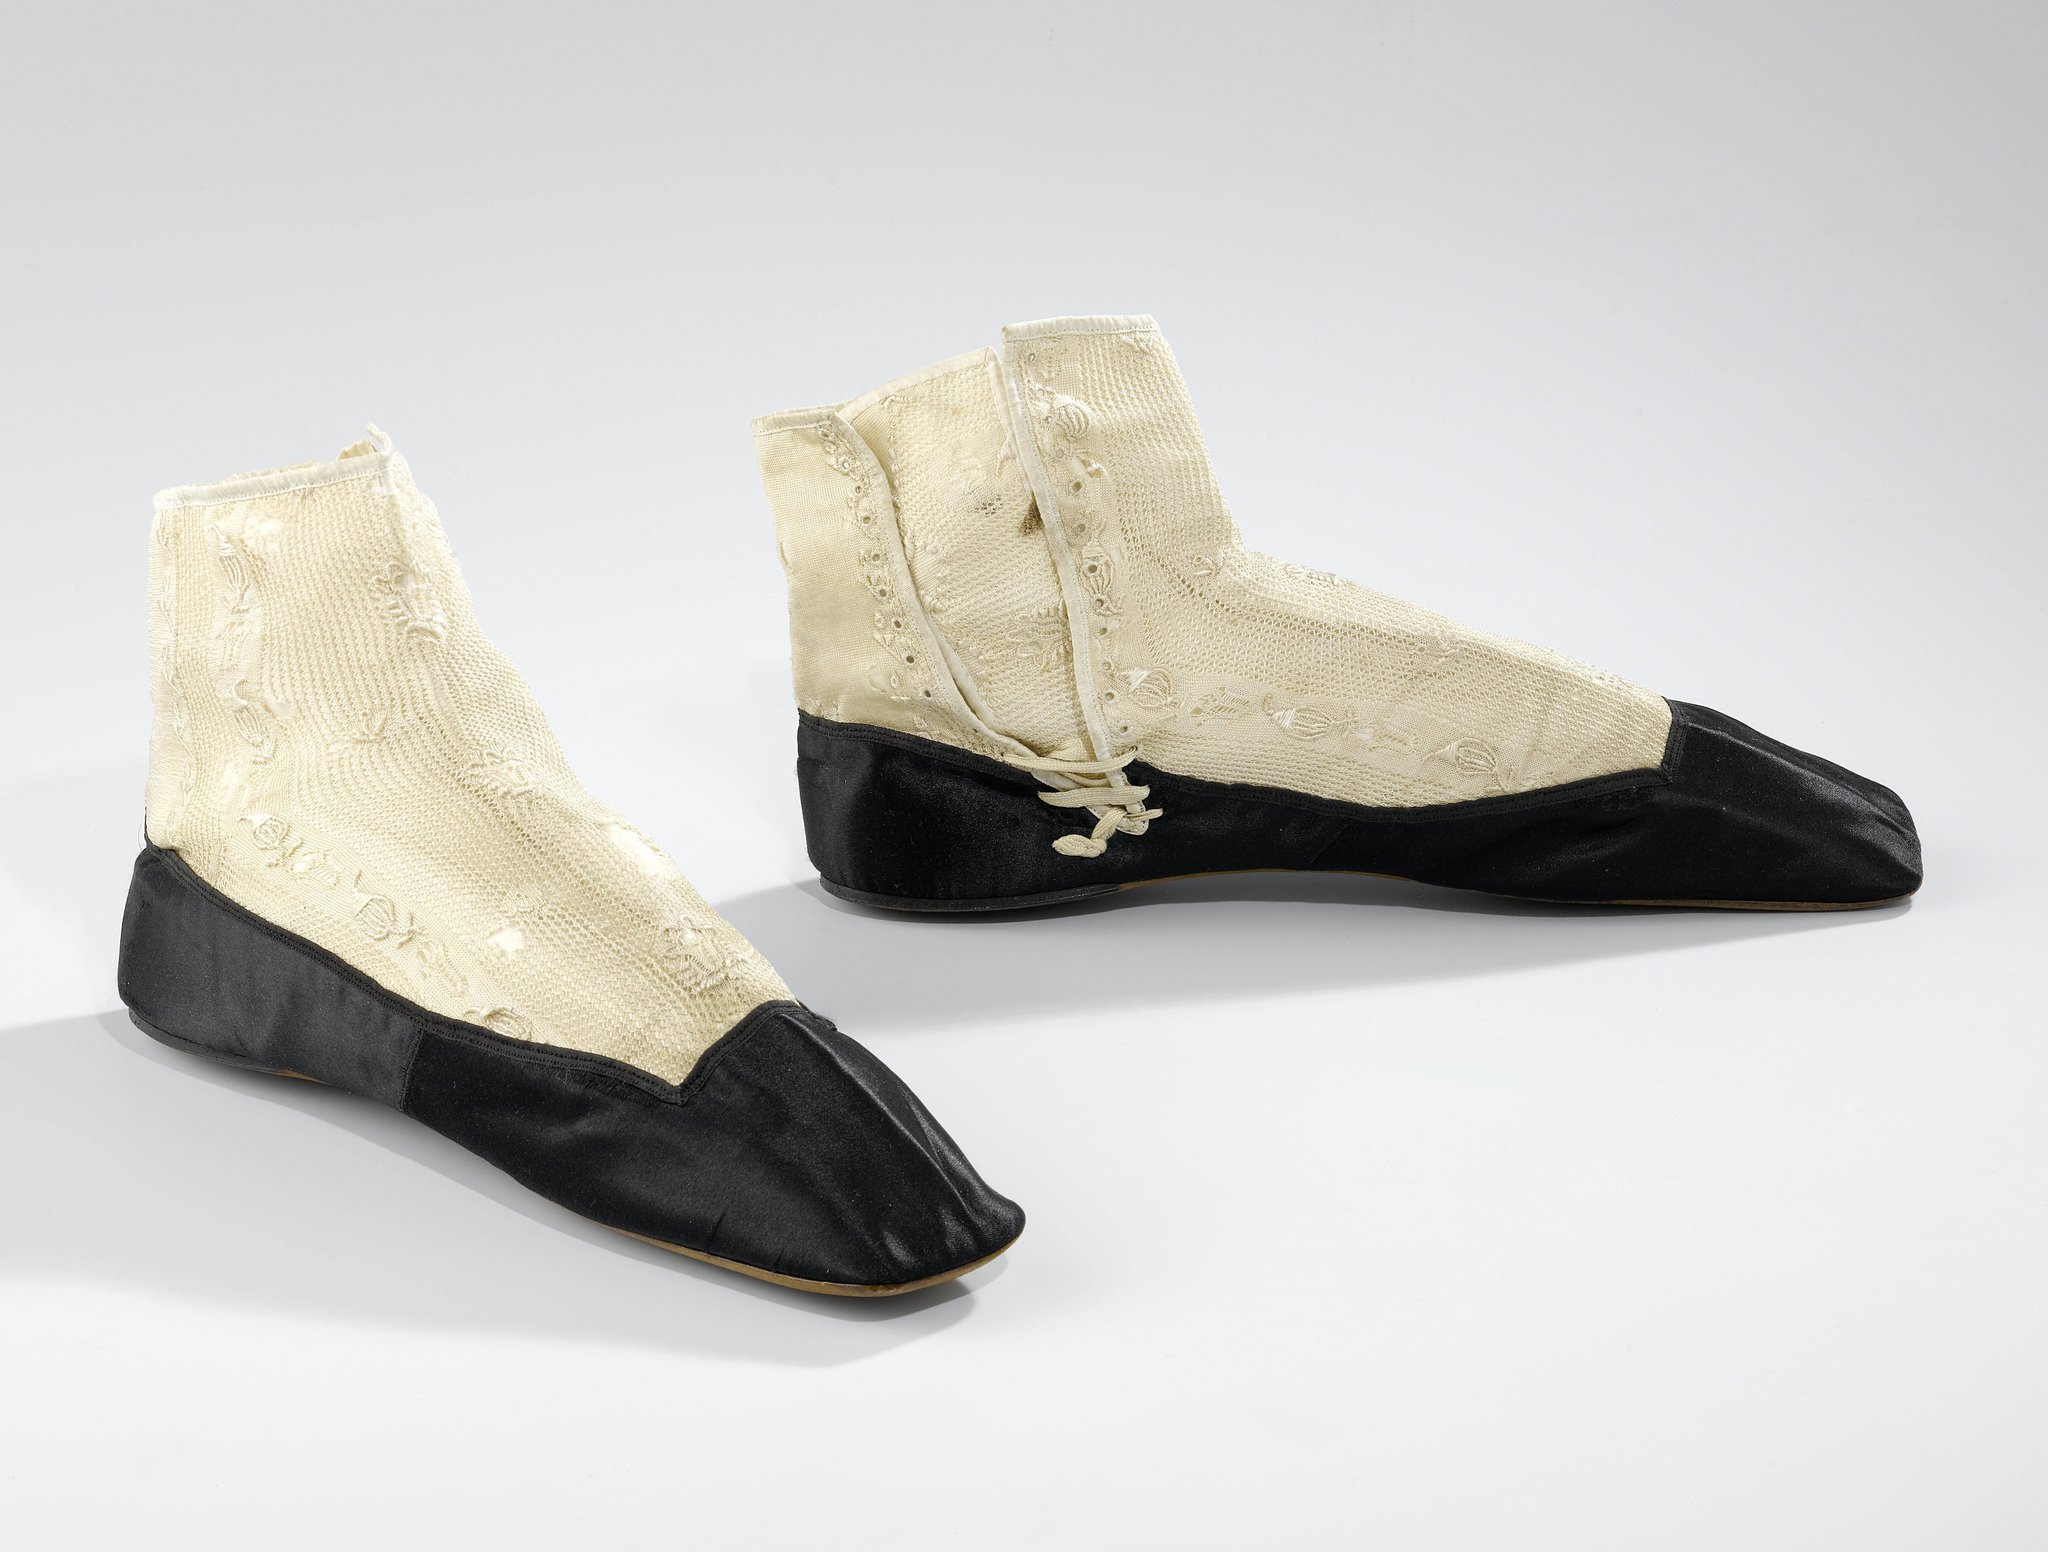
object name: bootie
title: Pair of ankle-length boots with shoe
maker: chalopin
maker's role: schoenmaker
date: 1830-1840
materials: leather, linen, silk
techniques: knitting, tanning, weave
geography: paris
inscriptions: address: ‘Chalopin./ Cordonnier pour Dames./ 102 rue Richelieu au 1 arr./ près le boulevart/ Ci dev-t rue Vivienne Paris’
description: These ankle-length boots were probably made from an older pair of shoes. When they went out of fashion, the Parisian cobbler Chalopin attached a silk tricot throat (stocking). This was tied at the side with a cord.